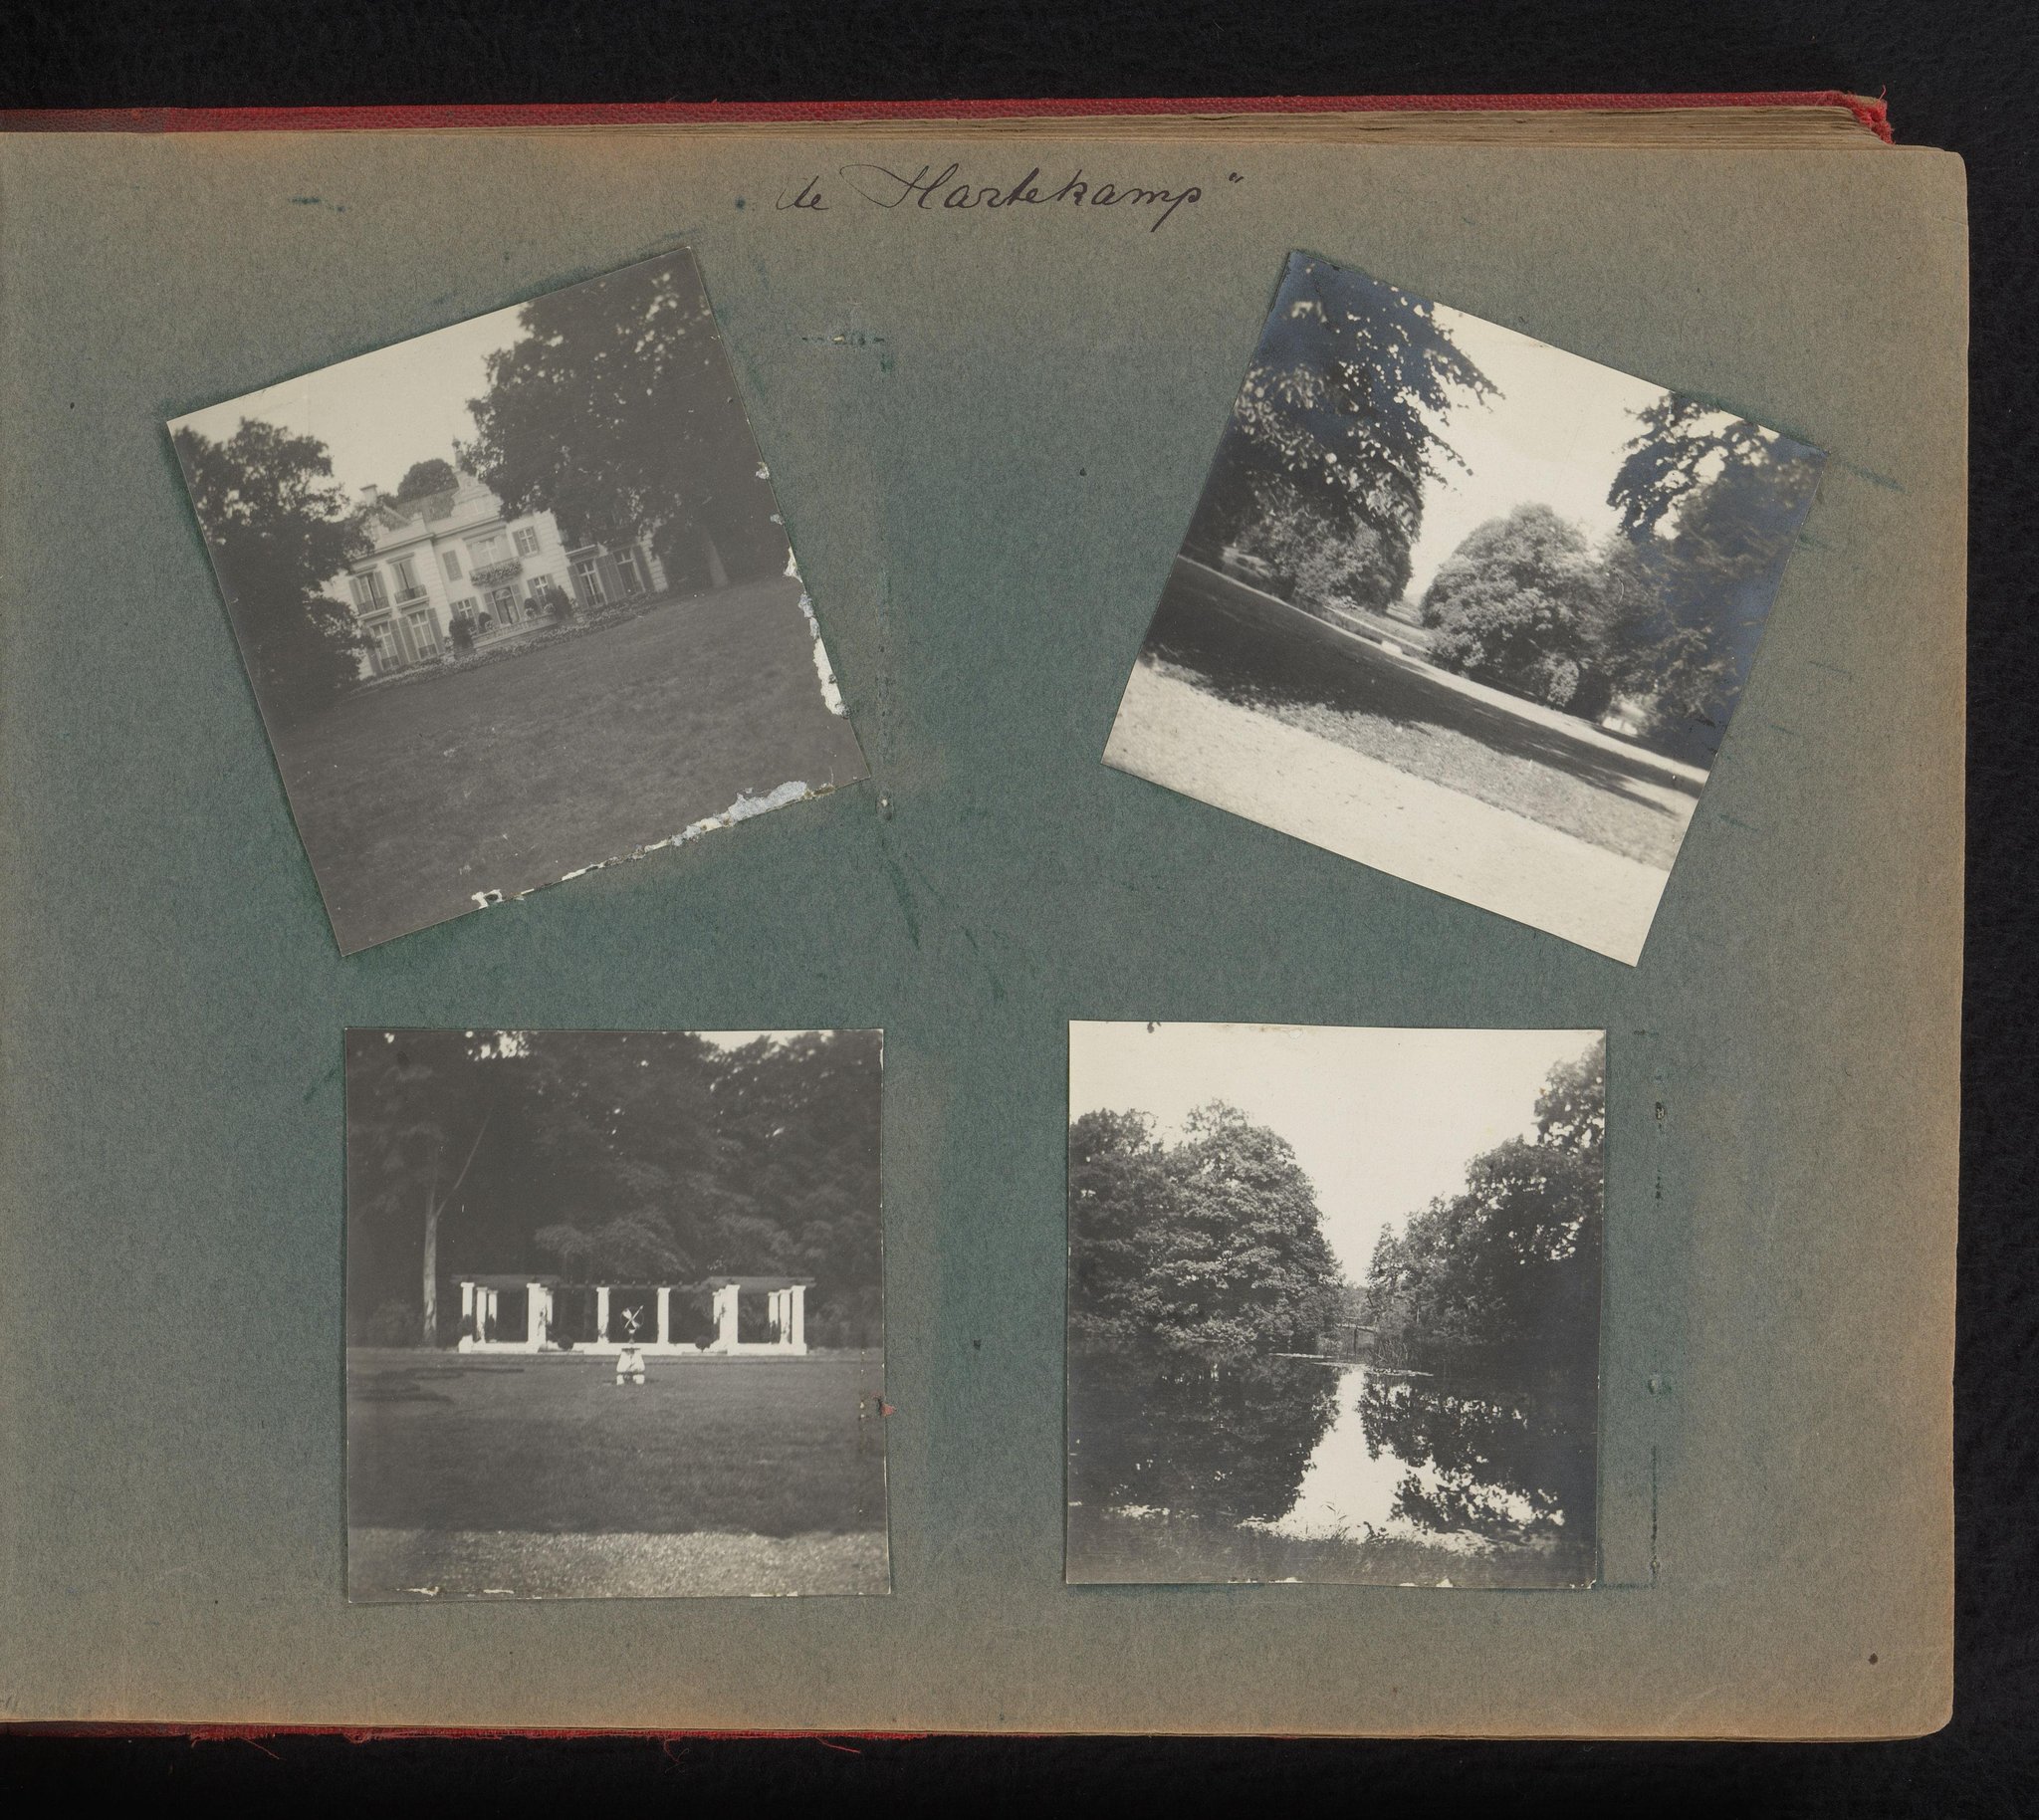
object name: photograph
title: De Hartekamp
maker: charlotte alida boelen-matthes (lot)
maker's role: amateurfotograaf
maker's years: 1889-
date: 1911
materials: paper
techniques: gelatin silver print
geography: heemstede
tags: amsterdam, thailand, garden, palace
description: Deze foto's zijn onderdeel van een album.